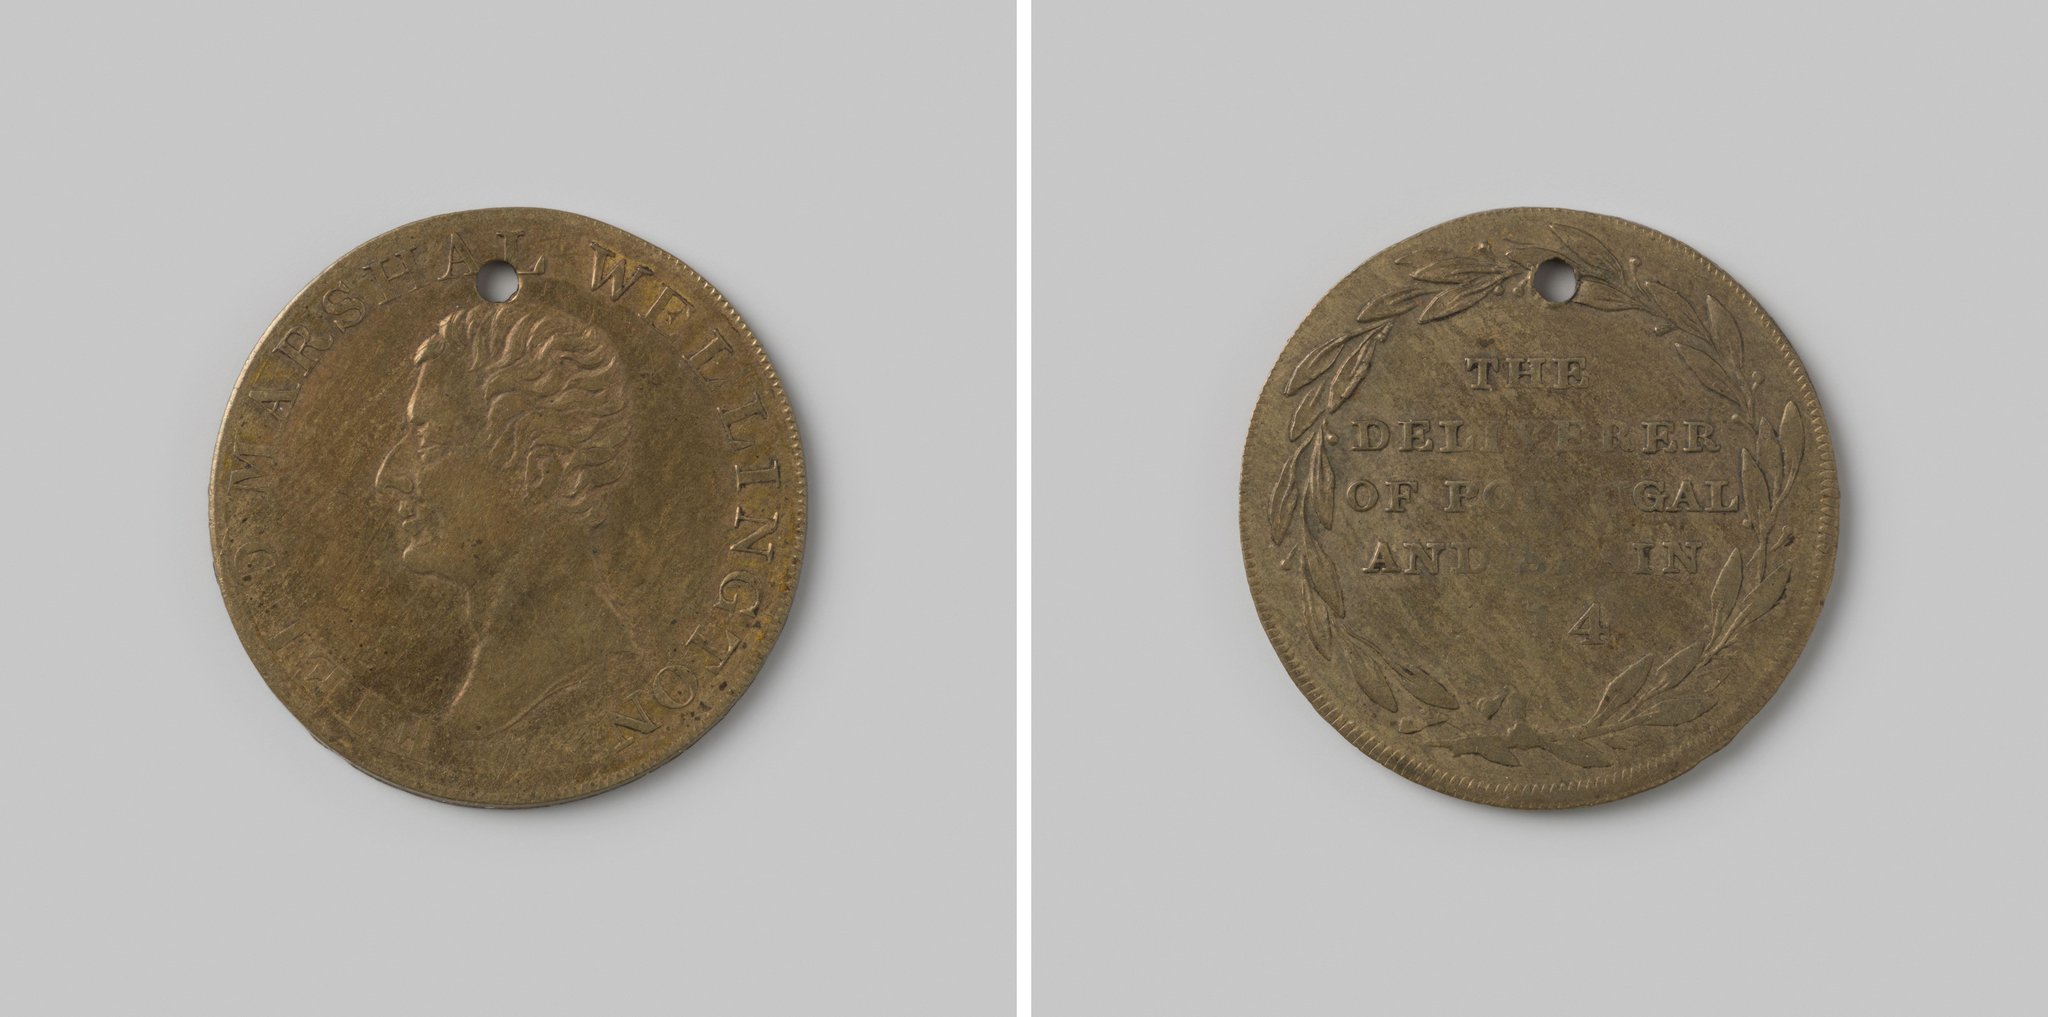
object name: history medal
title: De Hertog van Wellington als bevrijder van Portugal en Spanje 1814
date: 1814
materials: brass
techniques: striking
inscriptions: circumscription: ‘FIELD MARSHAL WELLINGTON’, inscription: ‘THE / DELIVERER / OF PORTUGAL / AND SPAIN / 1814’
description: Messing penning met doorboring, op de voorzijde het portret van de Hertog van Wellington, met omschrift, op de keerzijde vijf regels tekst in een lauwerkrans.